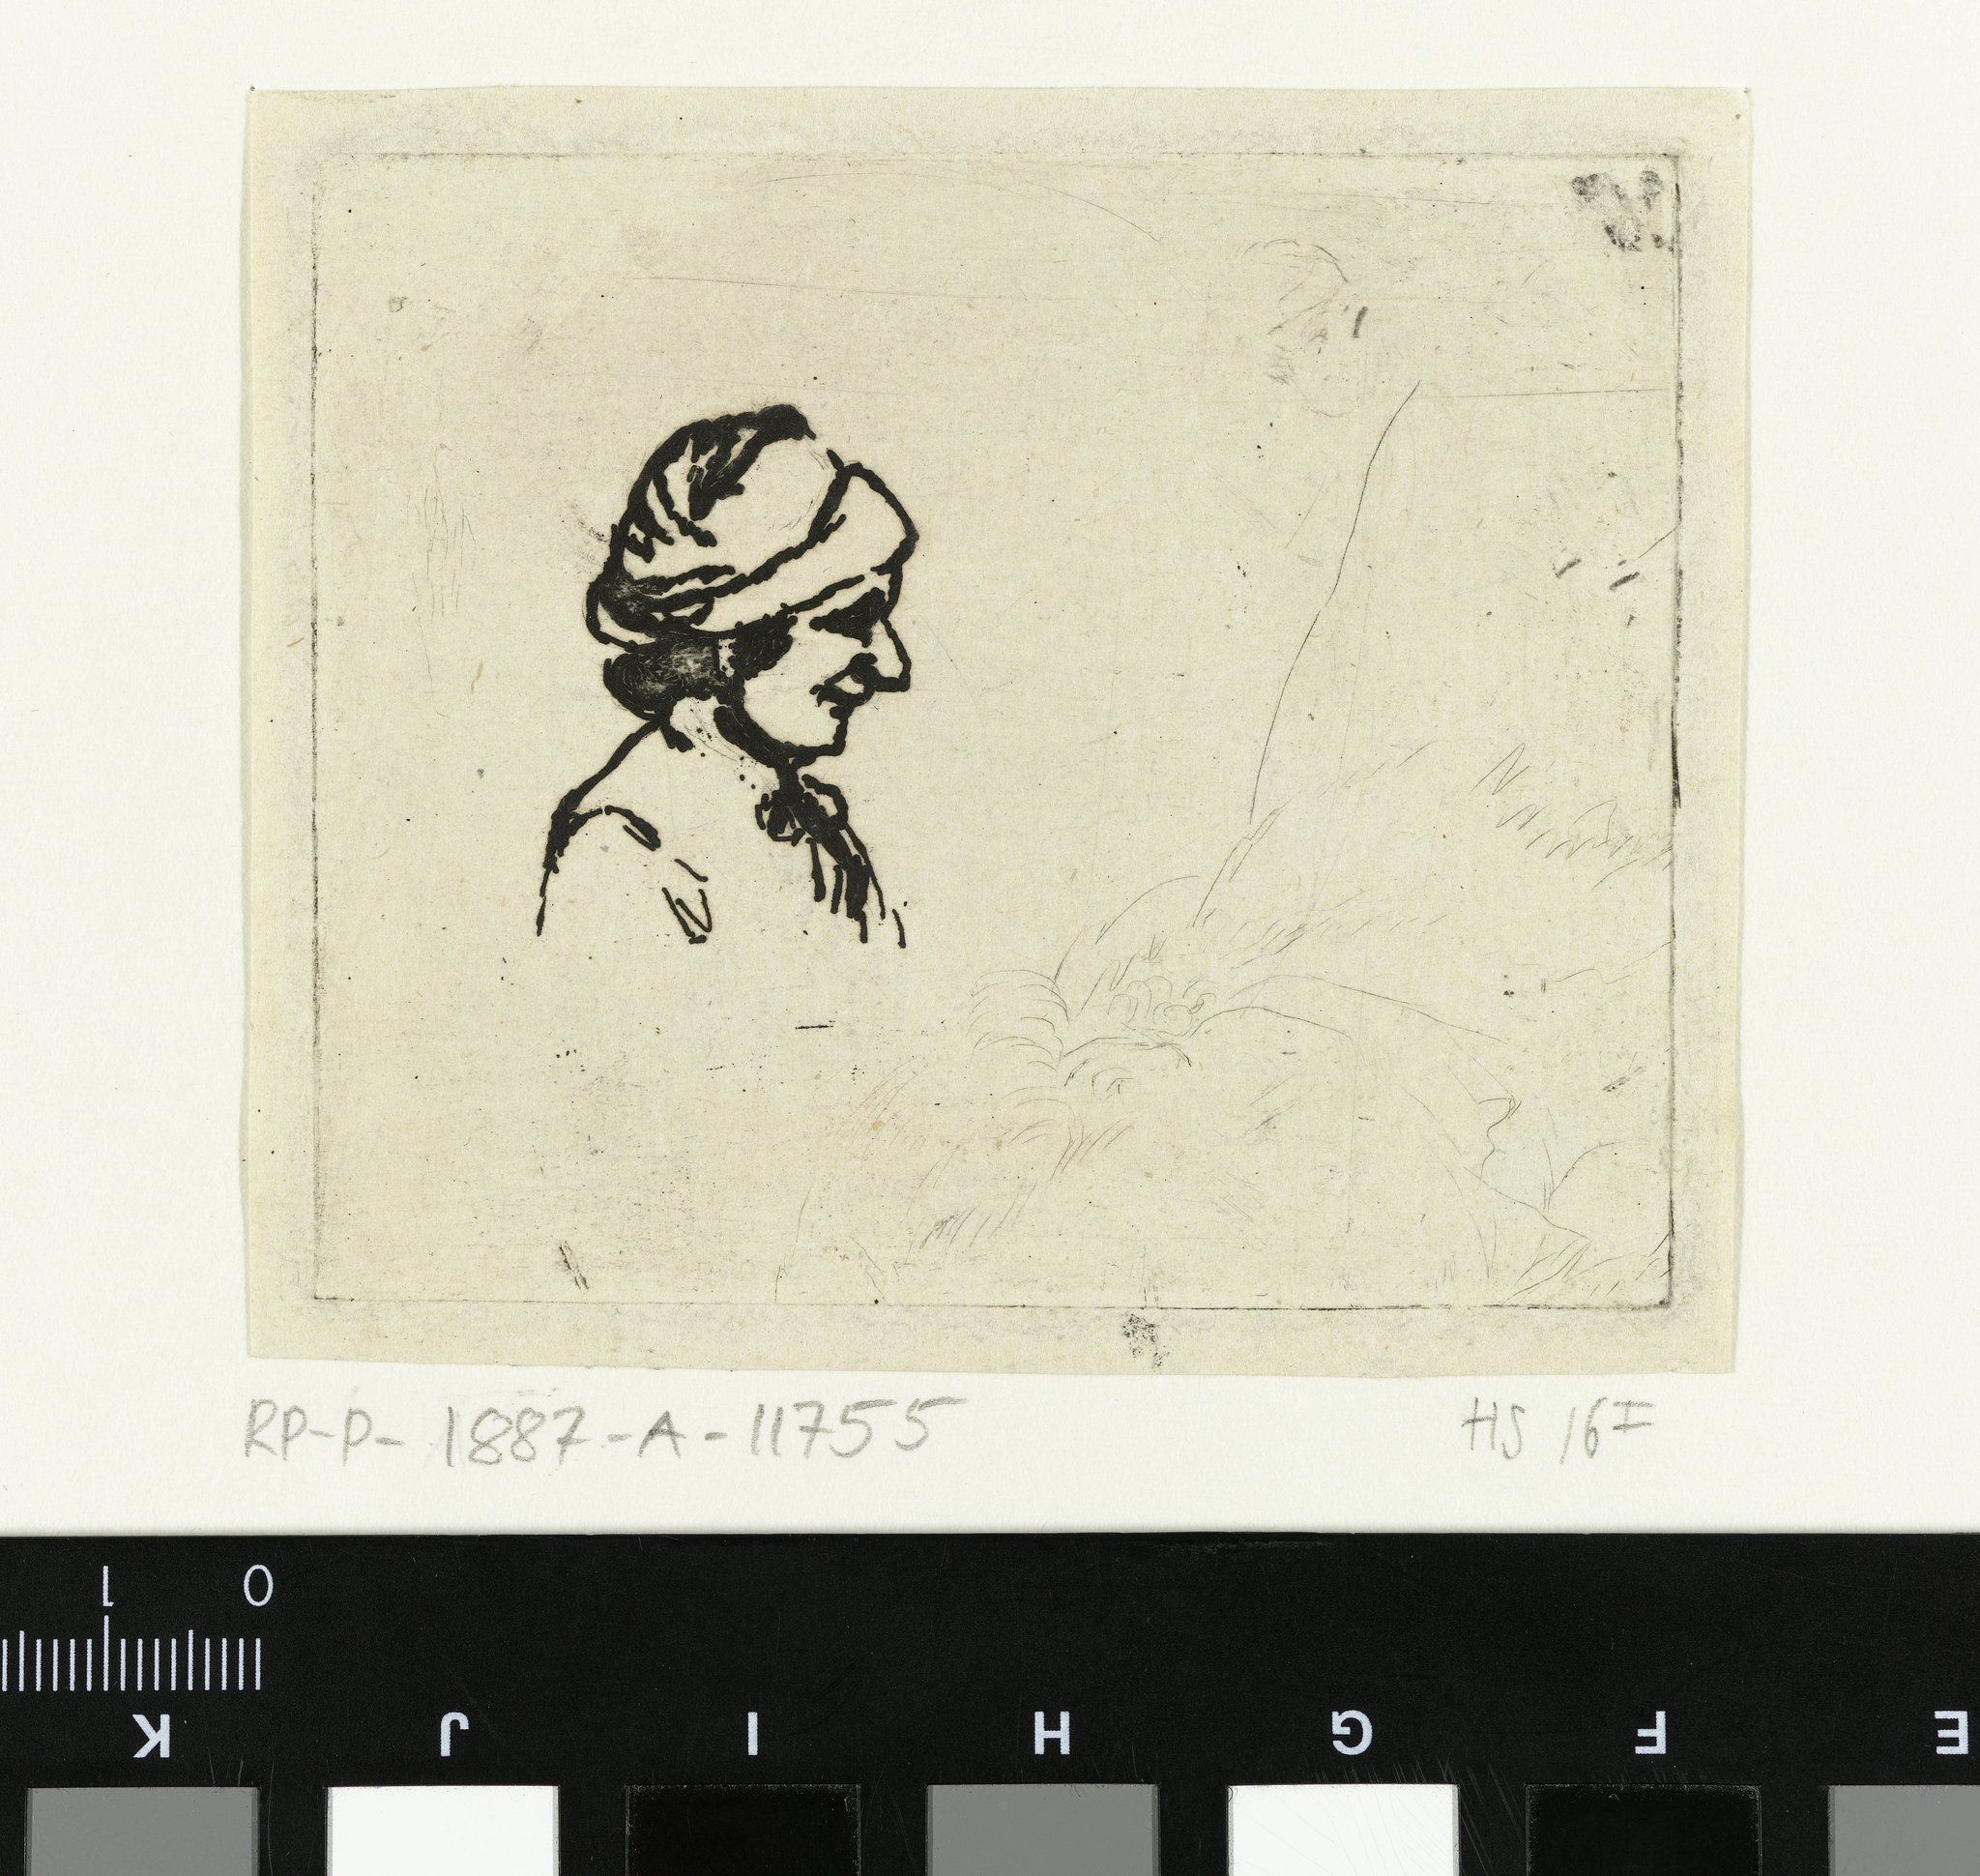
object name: print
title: Portretbuste van een man met muts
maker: marie lambertine coclers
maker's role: conservator, draughtsman, print maker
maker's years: 1761-1815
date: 1776-1815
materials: paper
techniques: etching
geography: amsterdam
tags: head-gear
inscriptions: collector's mark: Lugt 2228